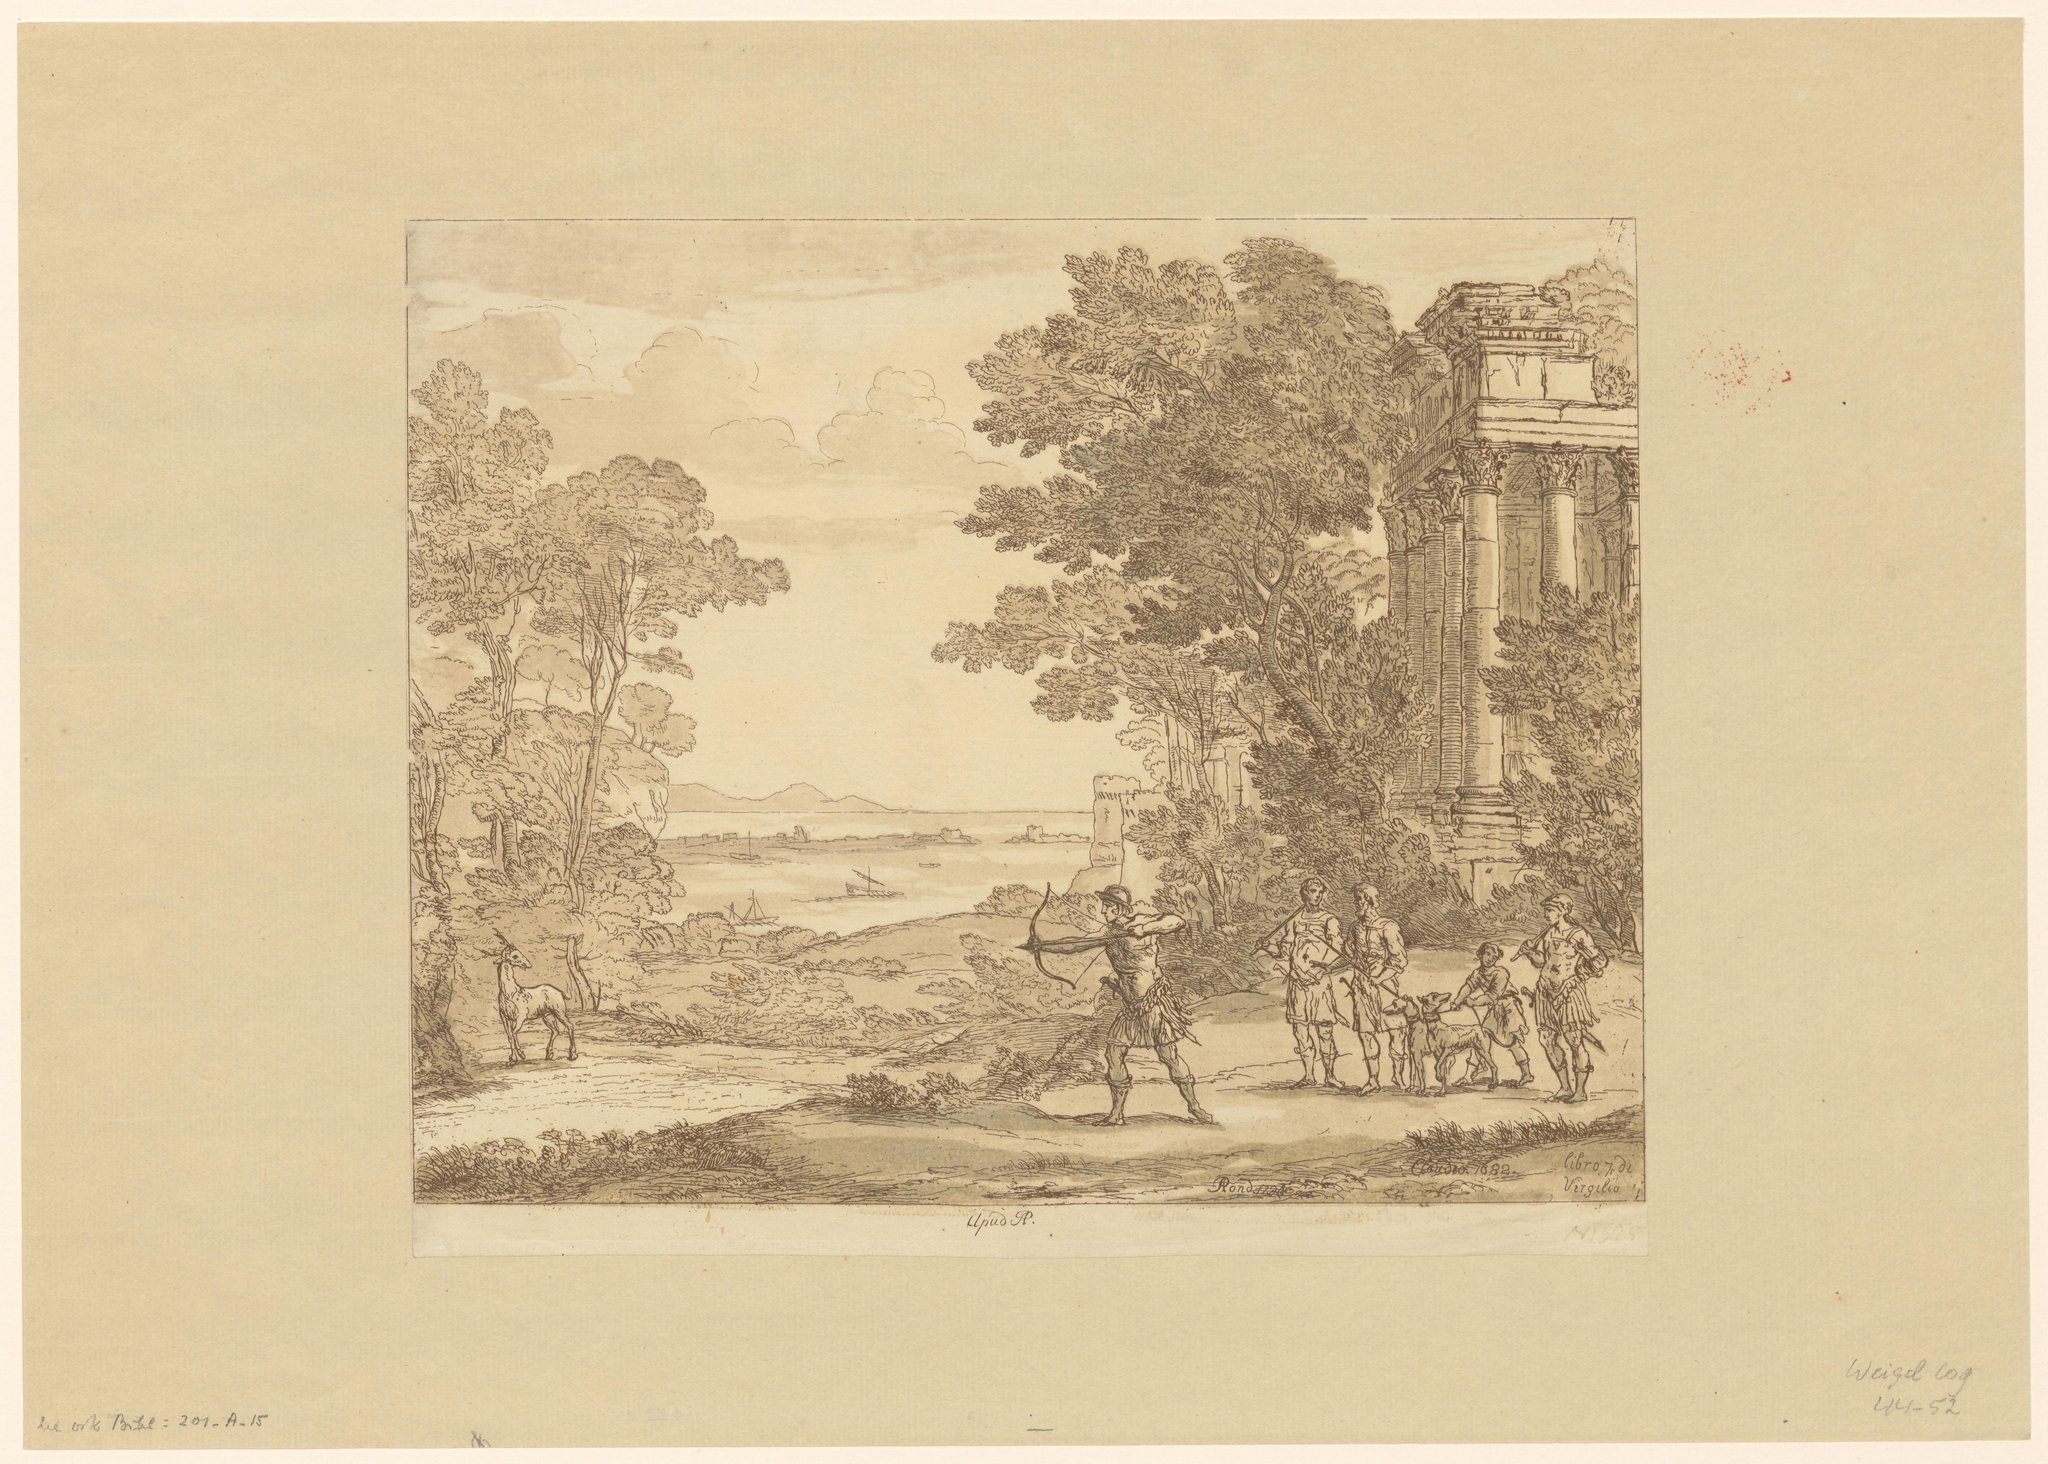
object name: print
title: Ascanius richt zijn pijl op het hert van Silvia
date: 1734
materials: paper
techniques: woodcut, etching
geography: great britain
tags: archer's weapons: bow and arrow, stag-hunting, when ascanius is hunting, alecto drives his hounds onto the trail of a sacred stag, landscape with ruins, dog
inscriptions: collector's mark: Lugt 240